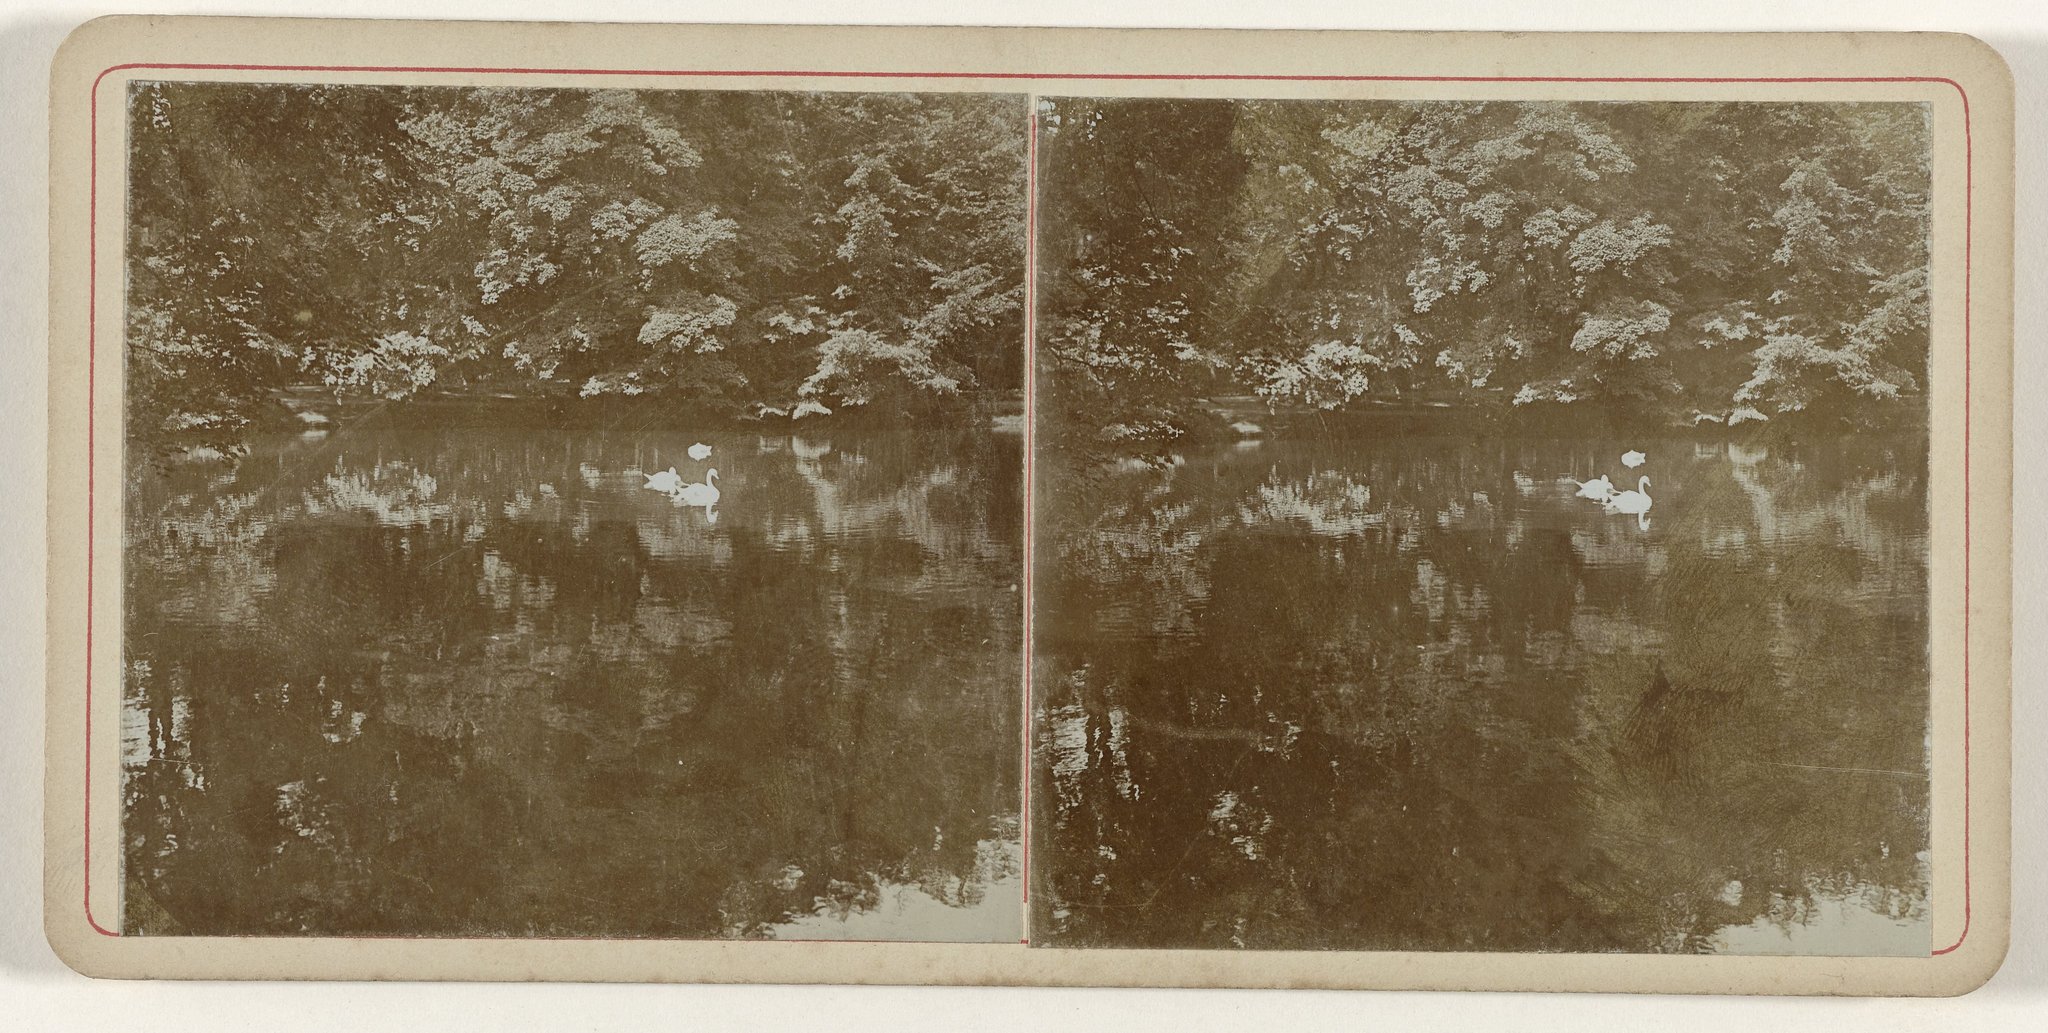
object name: stereograph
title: Vijver met zwanen gelegen in een boomrijke omgeving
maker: geldolph adriaan kessler (dolph)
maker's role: fotograaf, industrieel, voetballer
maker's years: 1884-1945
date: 1904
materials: paper, photographic support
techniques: collodion silver print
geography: gelderland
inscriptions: title: ‘Eerste vijver, juli 1904’